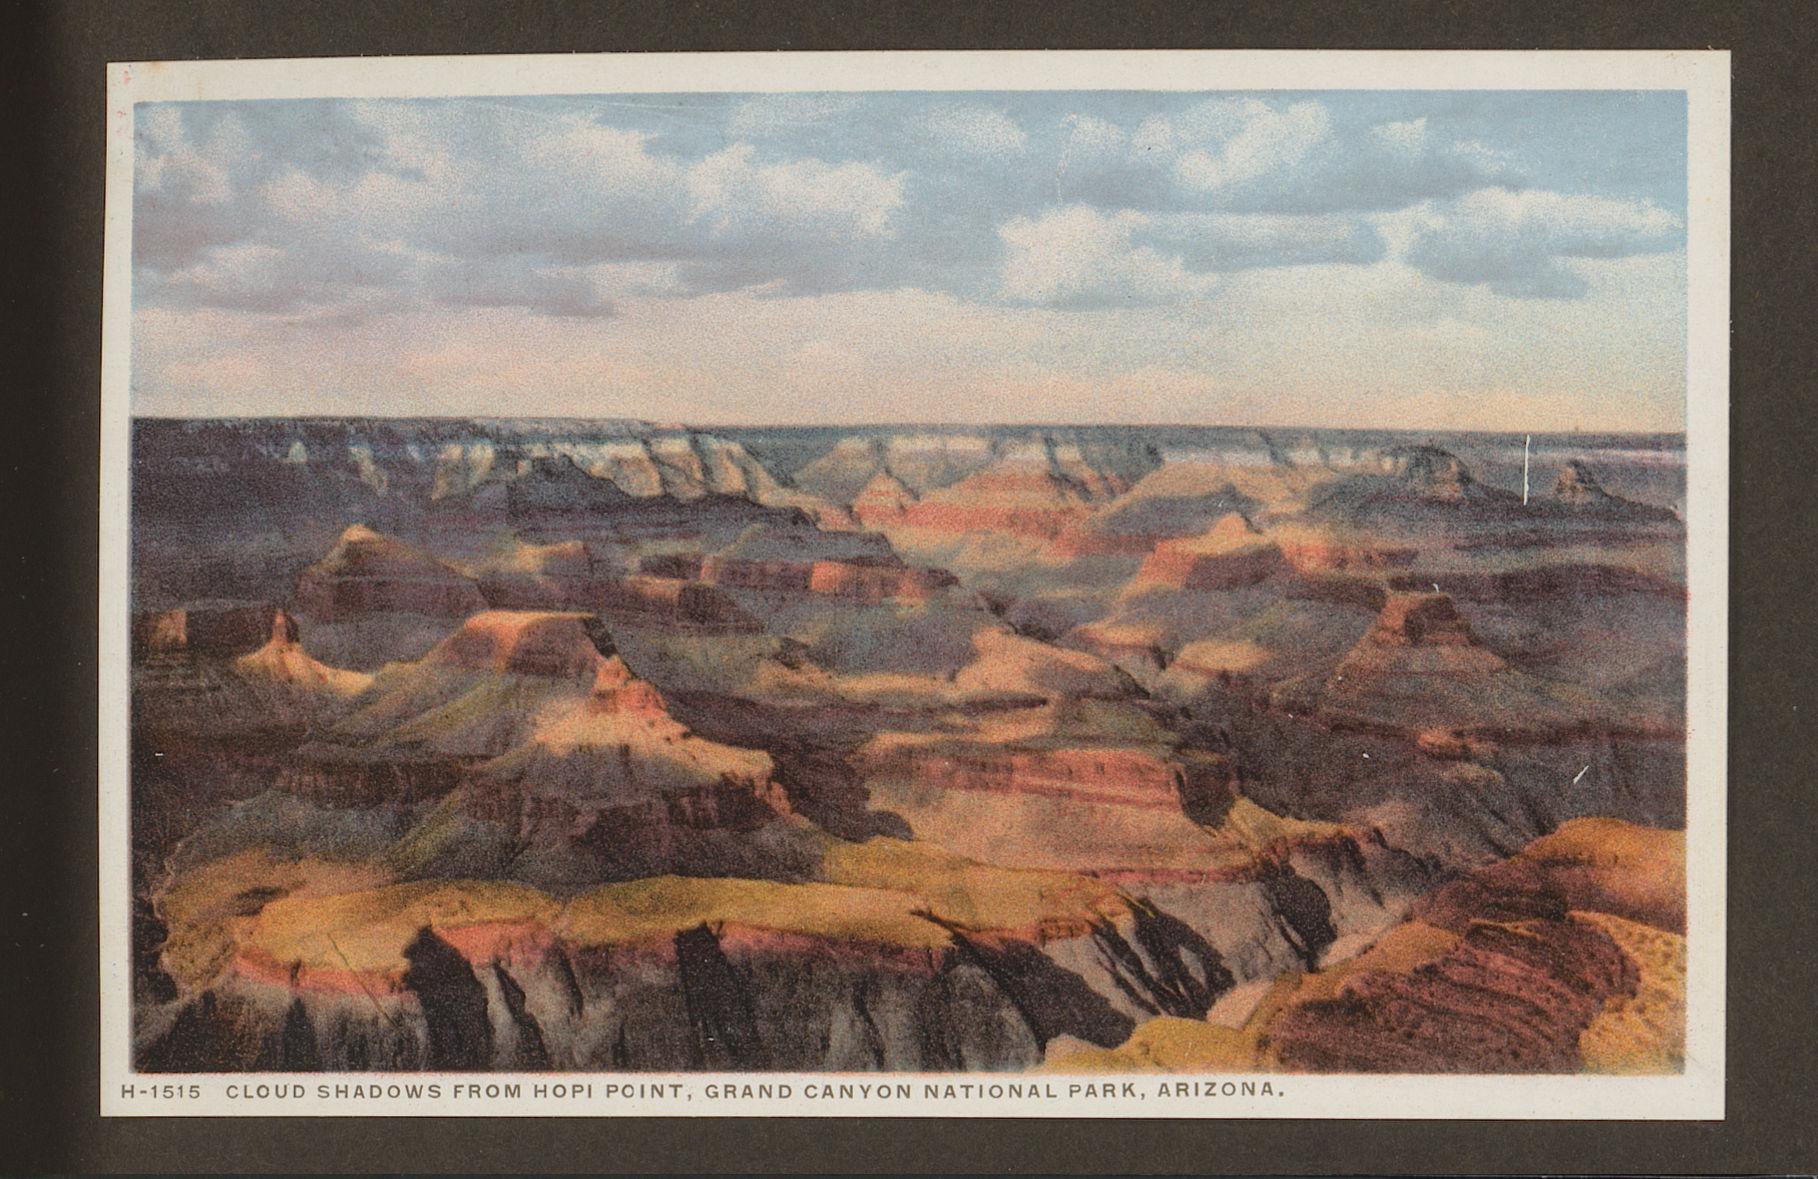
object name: photomechanical print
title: Cloud shadows from Hopi Point, Grand Canyon National Park, Arizona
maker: Anonymous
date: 1928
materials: paper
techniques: four-color autotype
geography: grand canyon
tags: clouds, ravine, chasm, abyss, canyon, shadow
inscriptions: number: ‘H - 1515’, annotation: ‘Grand Canyon’